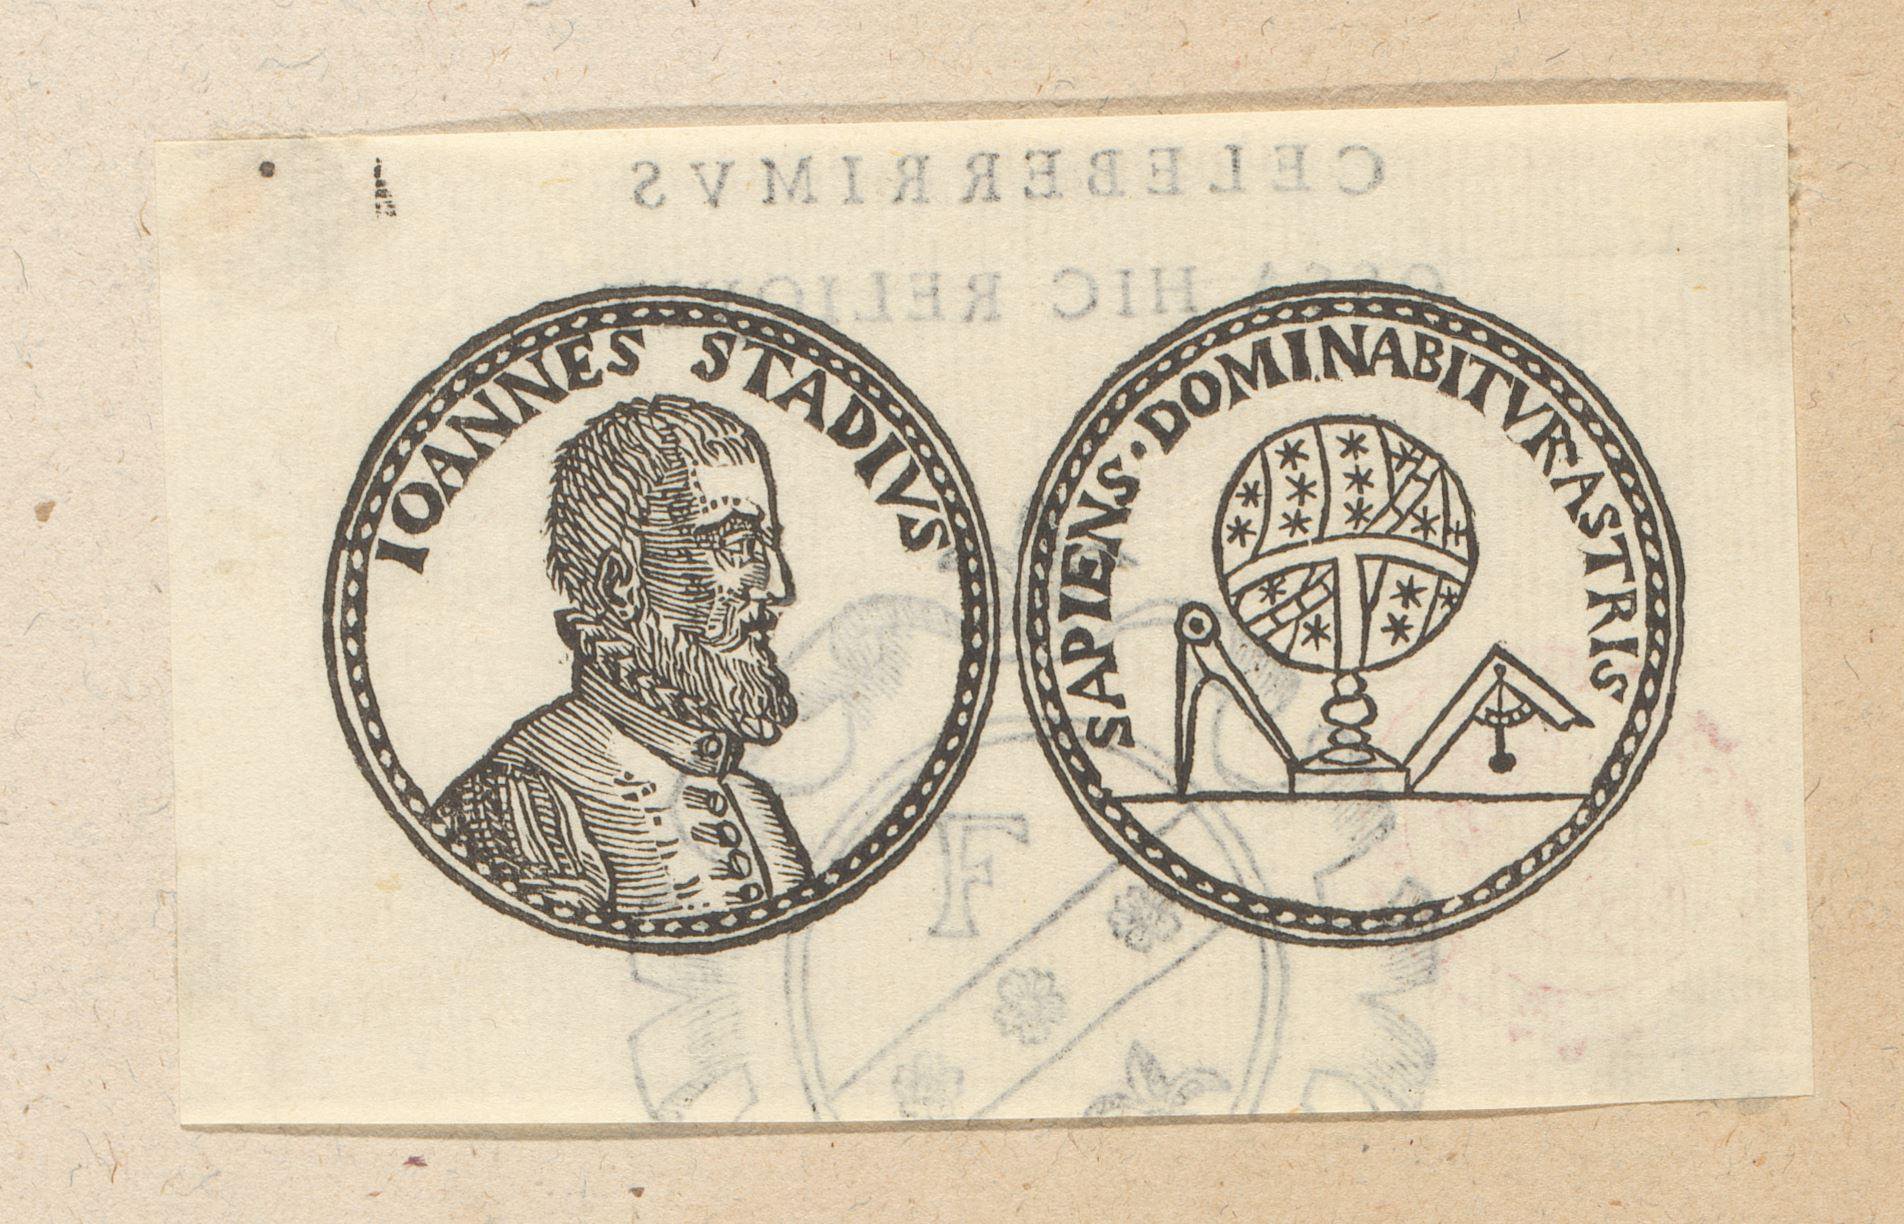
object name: print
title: Portret van Johann Stadius met globe en passers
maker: Anonymous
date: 1537-1579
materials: paper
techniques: letterpress printing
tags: paris, astronomy (and cosmography) (+ portrait of scholar, scientist), historical persons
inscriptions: collector's mark: Lugt 240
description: Tekst in het Duits in de medaillons: 'Ioannes Stadius' en 'Sapiens Dominibatur Astris.' Prent maakt deel uit van een album.